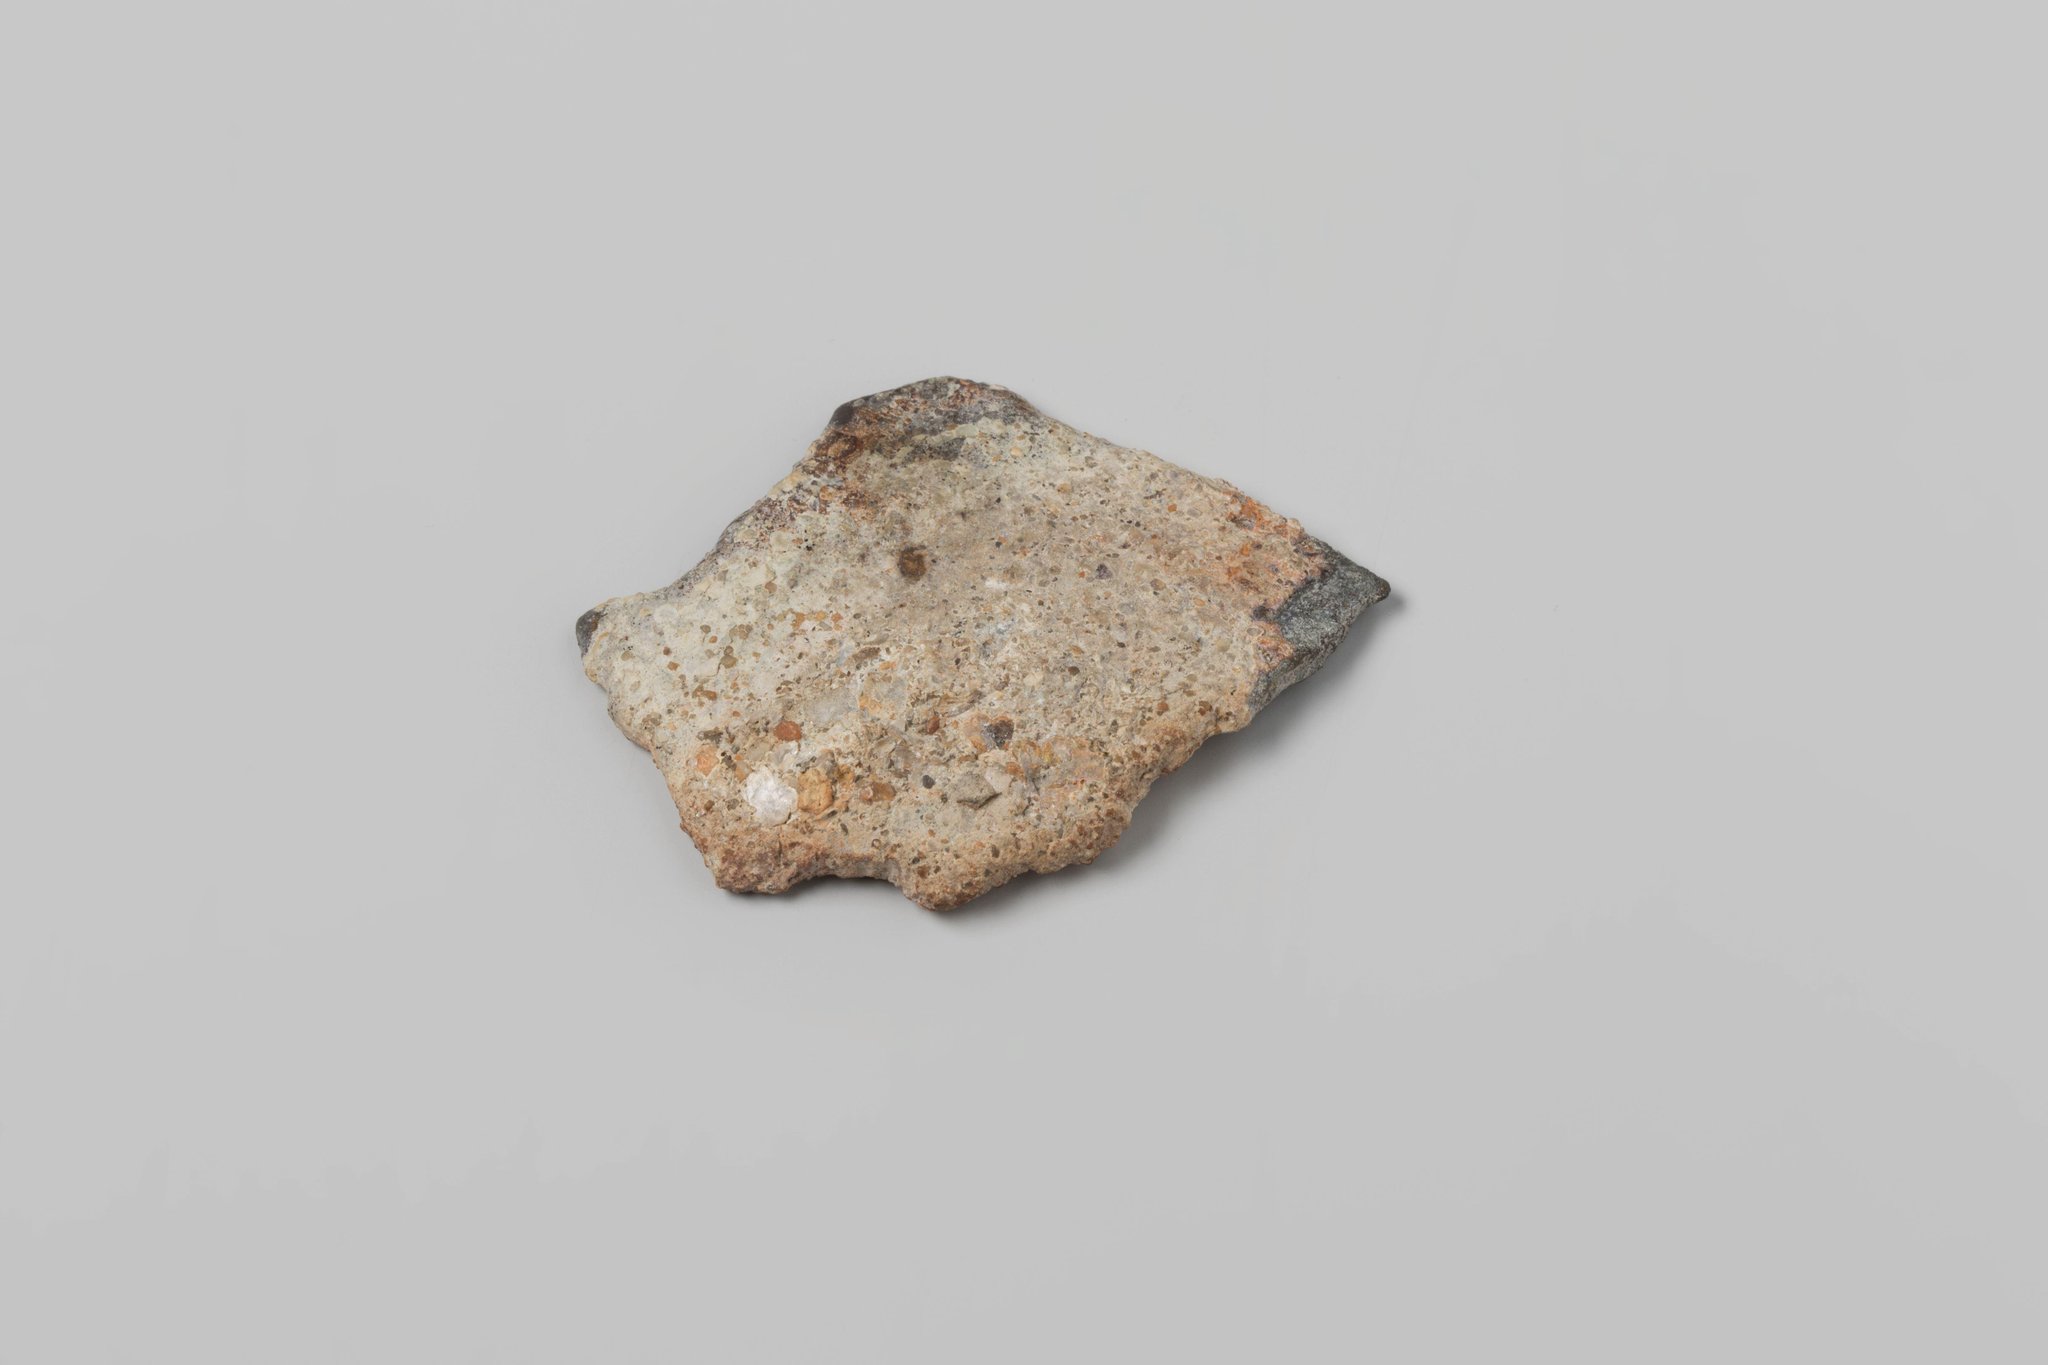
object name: fragment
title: Fragment koper uit het wrak van de Oost-Indiëvaarder Hollandia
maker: Anonymous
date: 1700-1743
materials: copper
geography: netherlands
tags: verenigde oostindische compagnie, hollandia (schip), annet